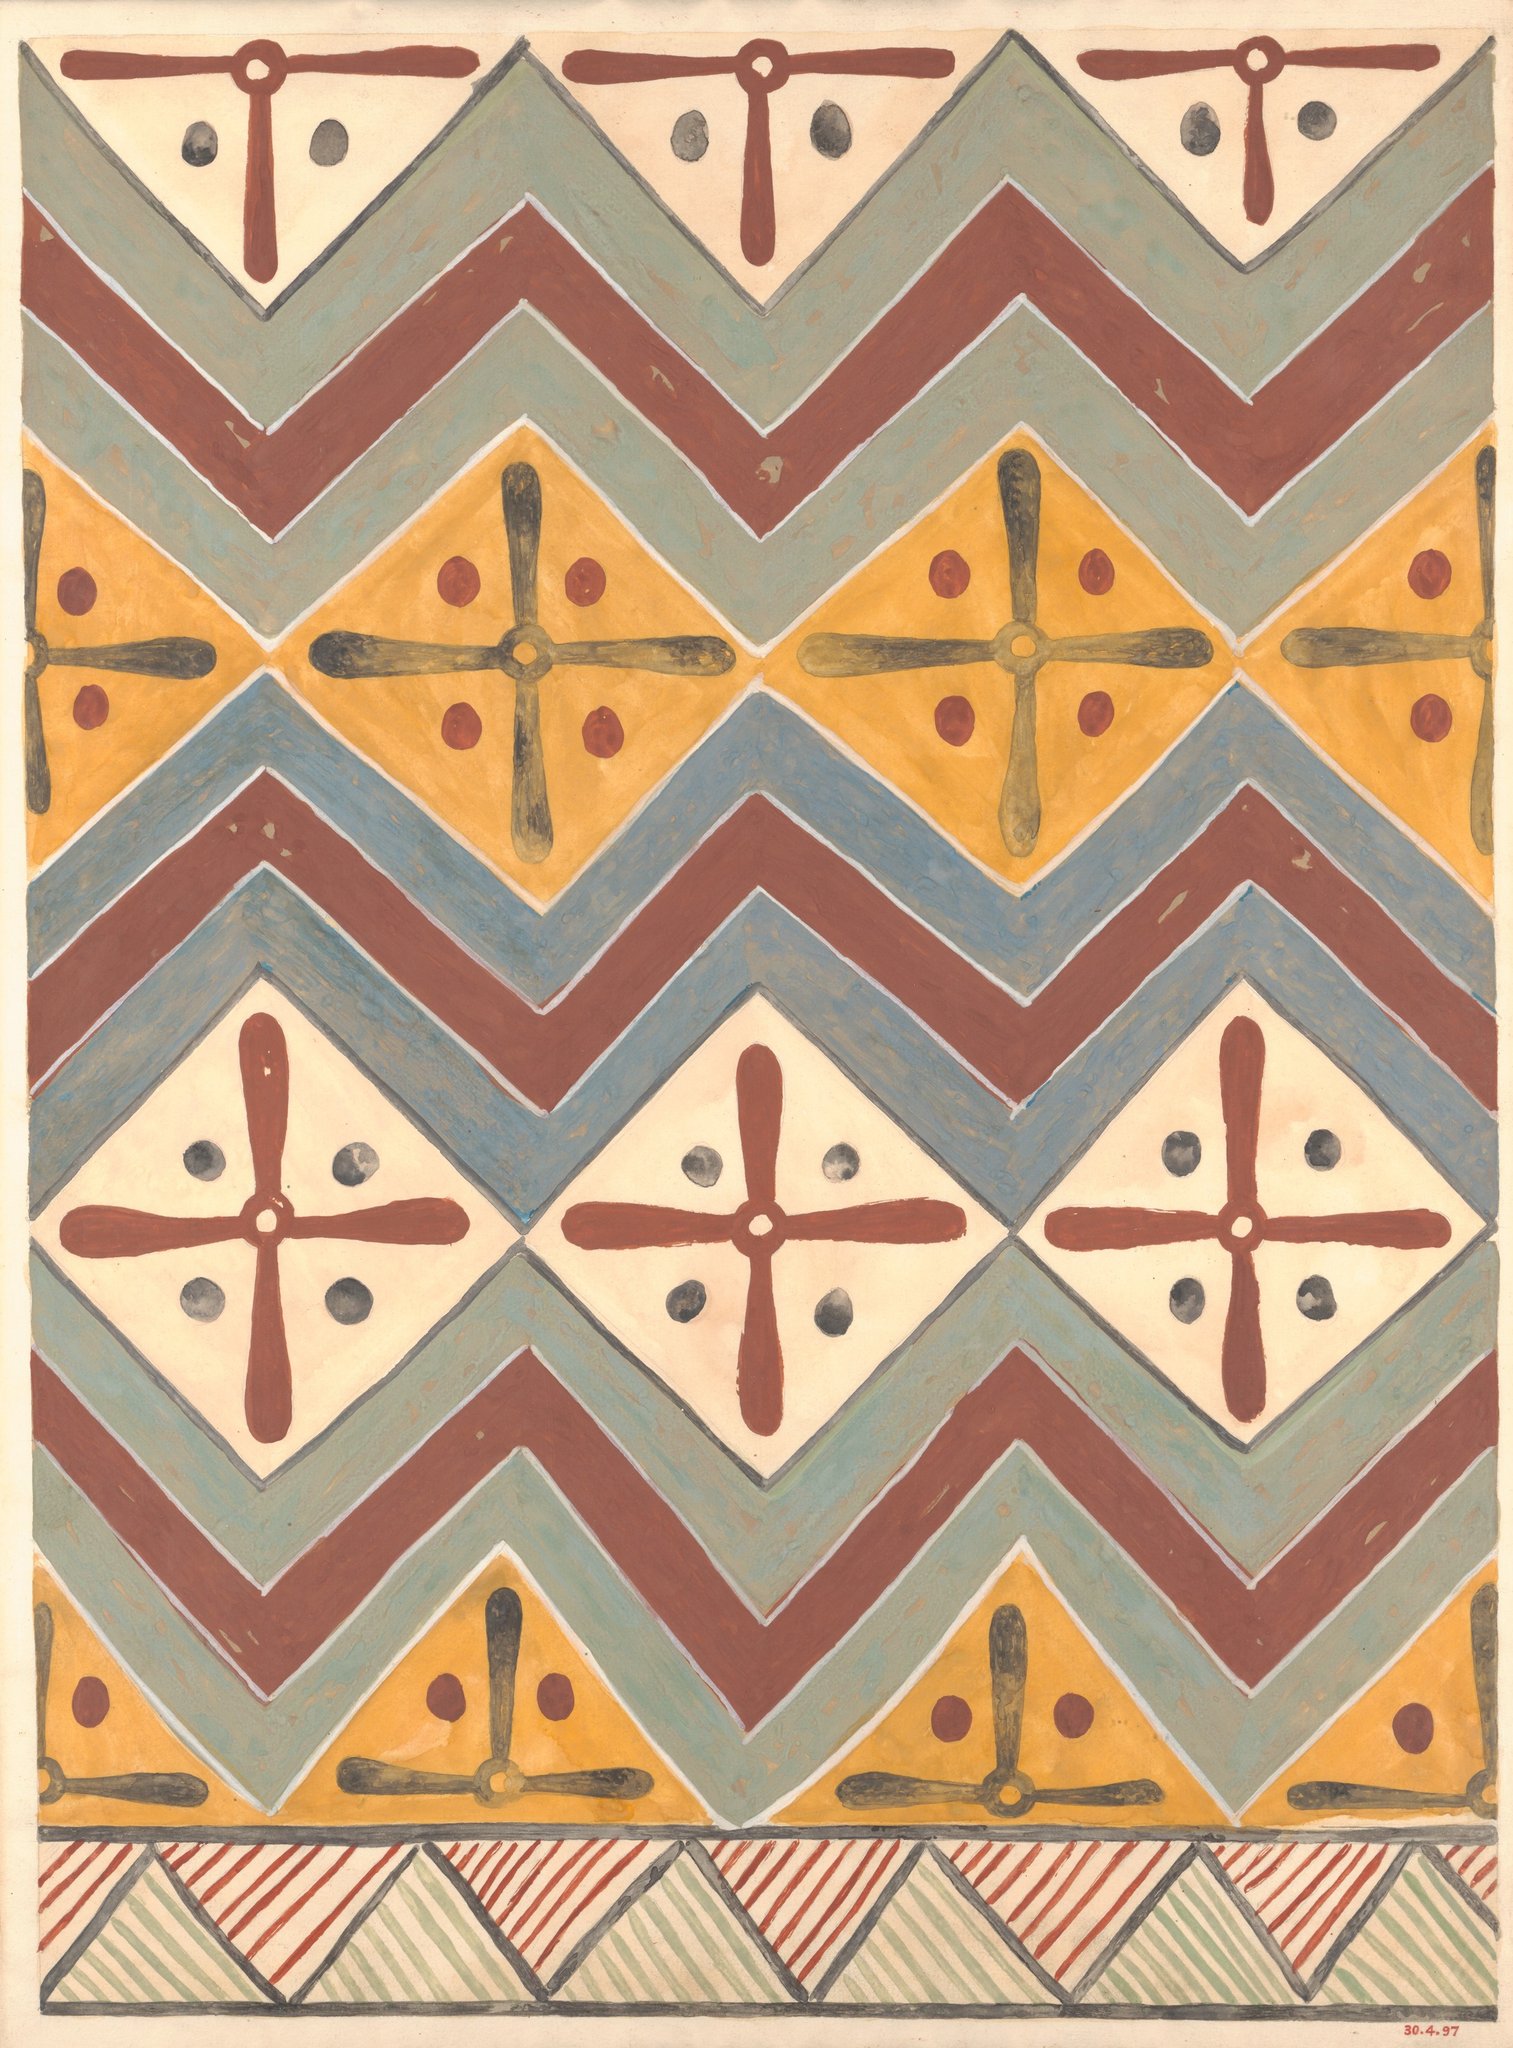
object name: facsimile, qenamun tt 162, ceiling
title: Ceiling Pattern, Tomb of Qenamun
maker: charles k. wilkinson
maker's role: artist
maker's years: 1897-1986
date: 1479-1400 BCE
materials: paper, paint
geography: egypt